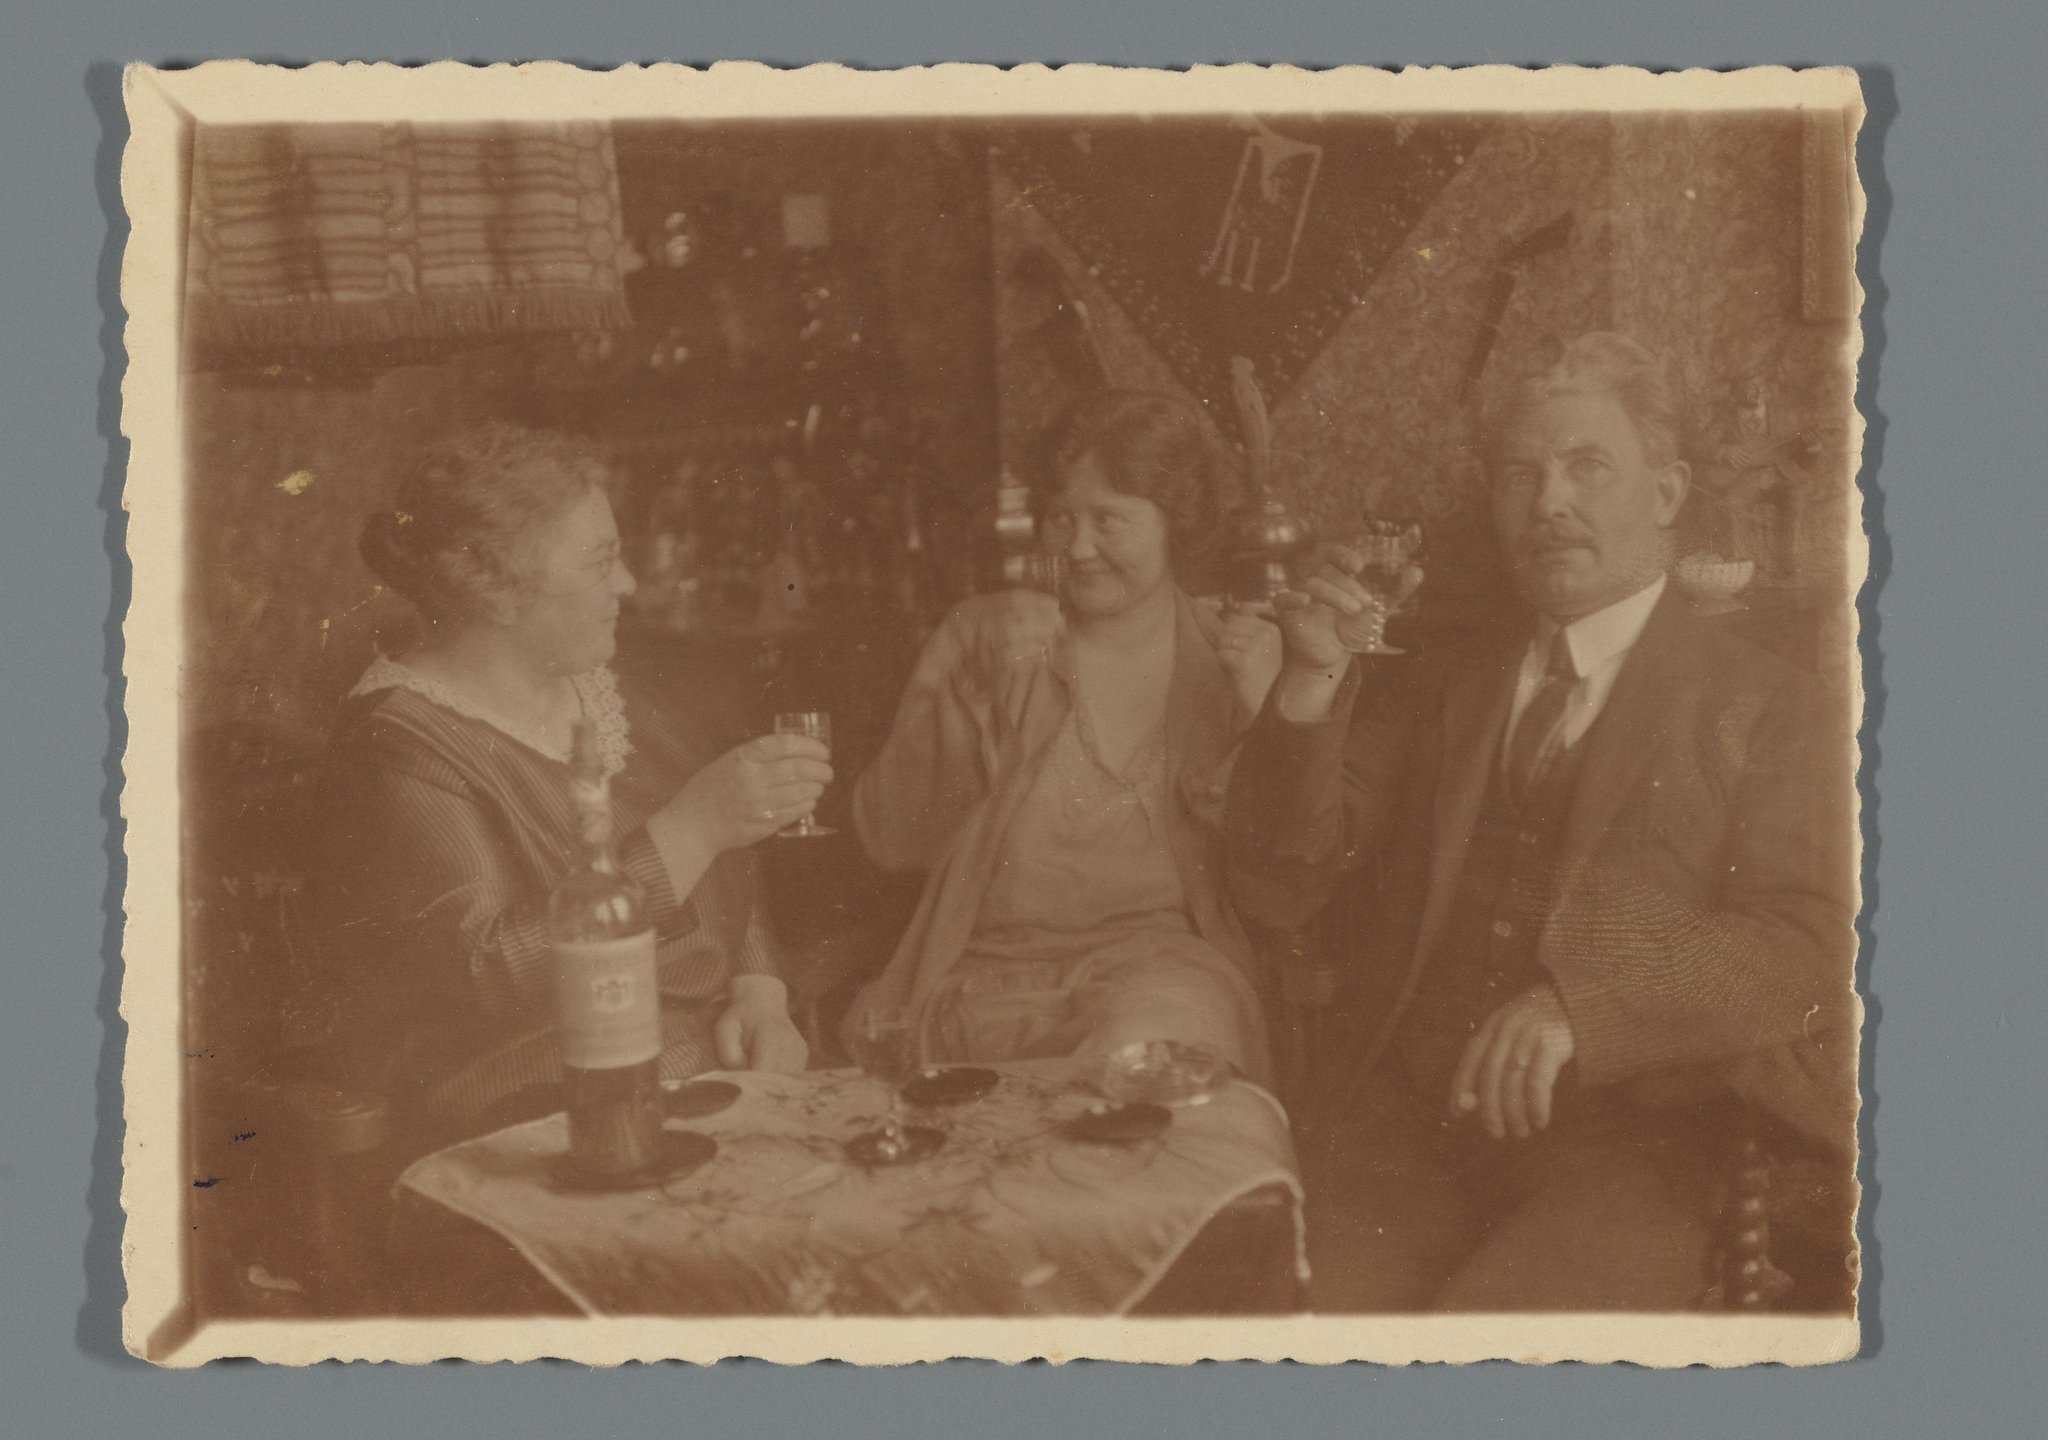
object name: photograph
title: Edith Jetten proostend met een oudere man en vrouw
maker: Anonymous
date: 1925-1927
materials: photographic support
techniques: photography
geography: suriname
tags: jetten, familie, moengo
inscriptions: inscription: ‘afscheid naar Suriname’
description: Edith Jetten proostend met een oudere man en vrouw, waarschijnlijk haar ouders, in Nederland voor het vertrek naar Suriname. Onderdeel van het ensemble met foto's van de familie van ingenieur Jetten in de mijnbouwstad Moengo in Suriname.